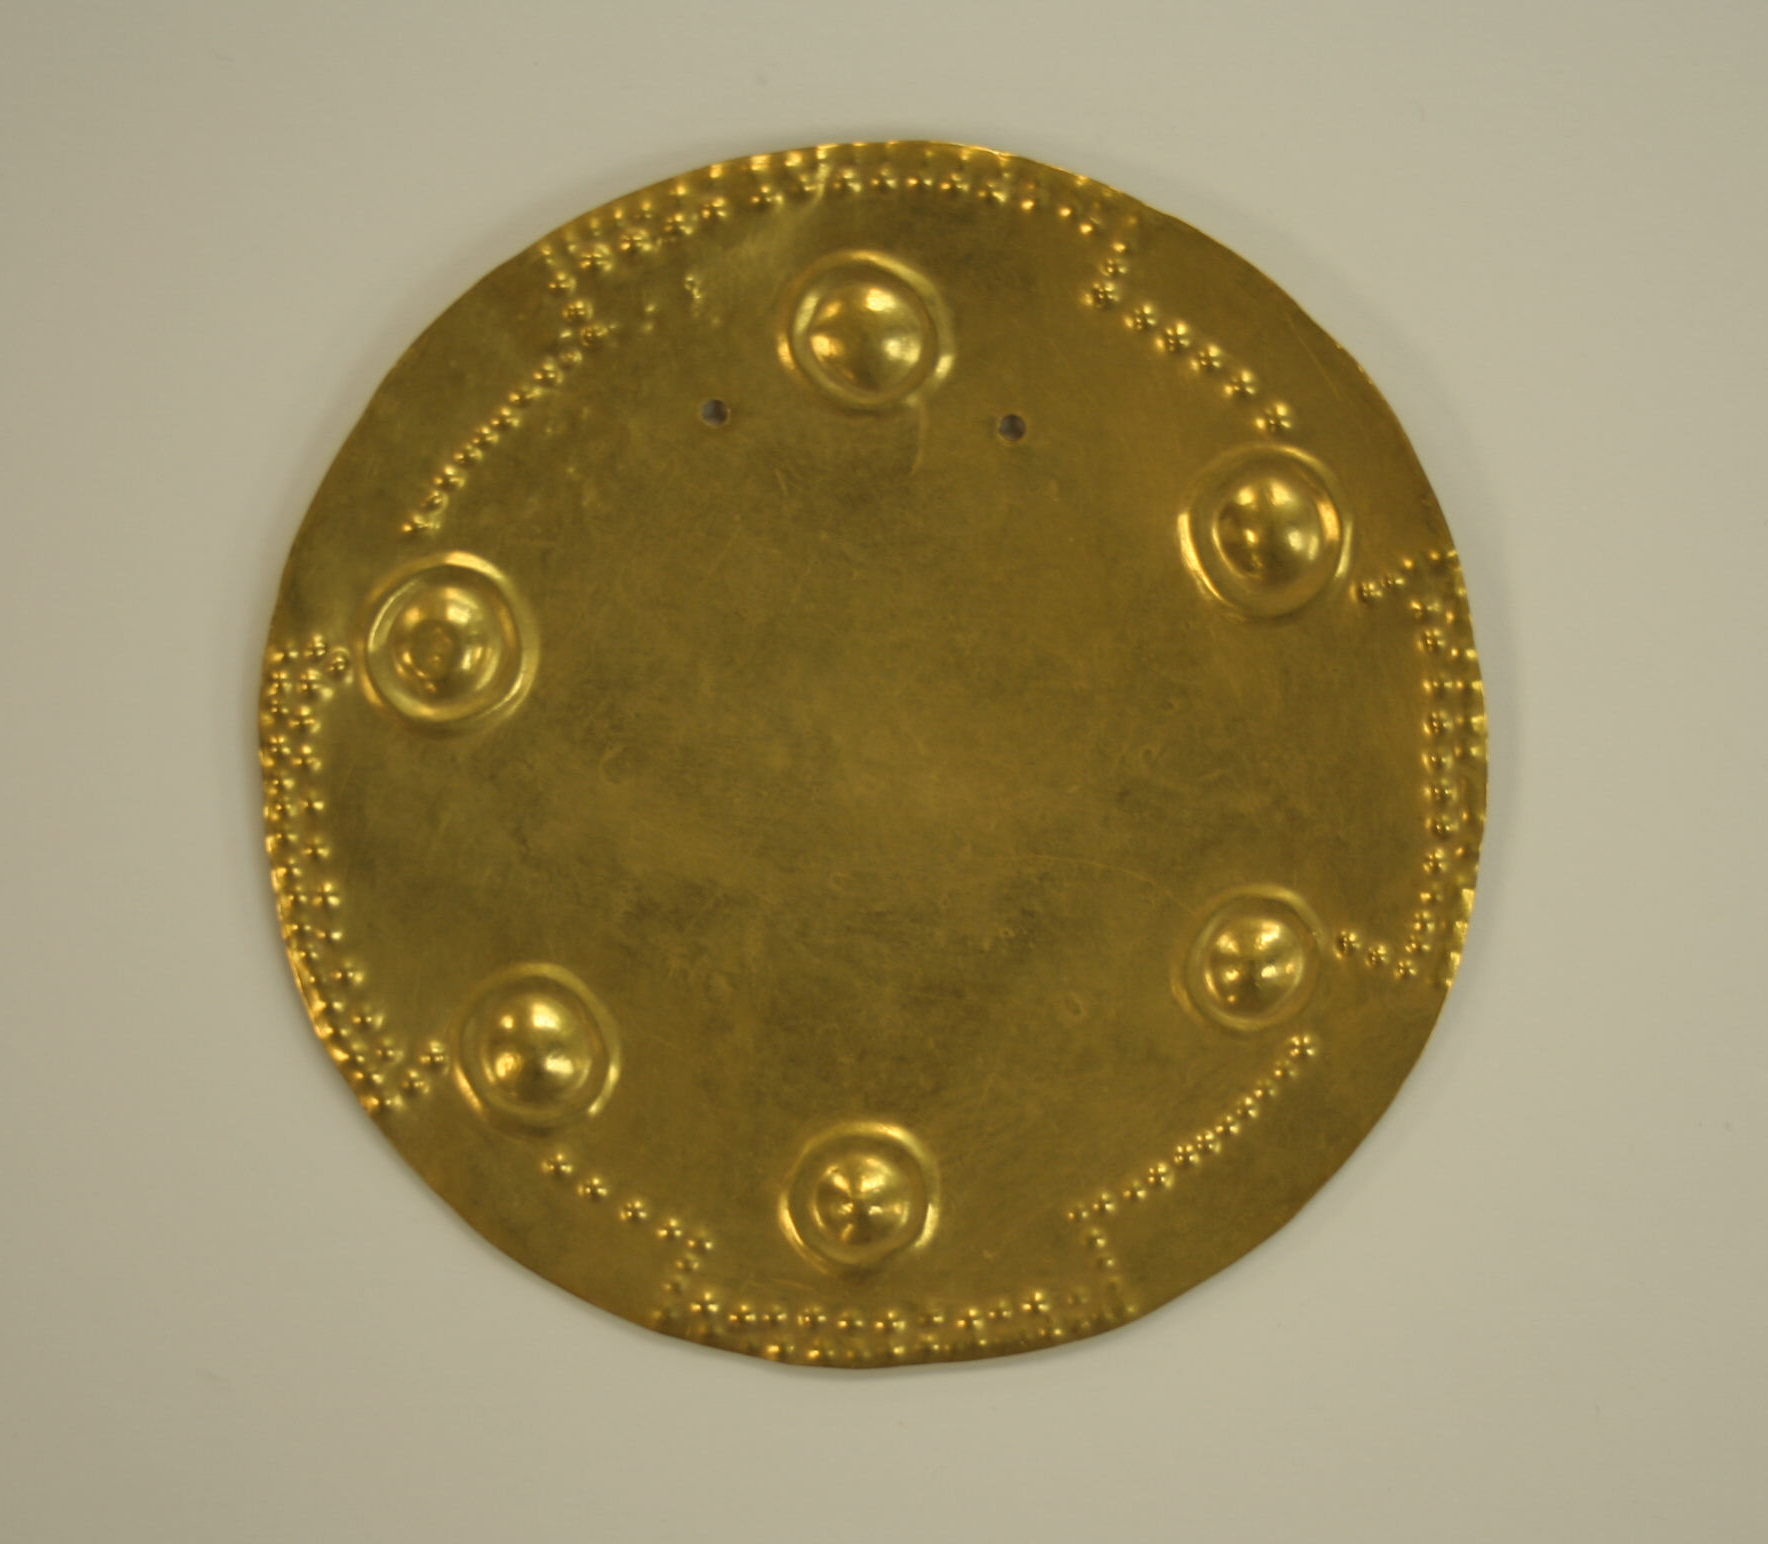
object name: pectoral disk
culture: colombian or panamanian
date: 701-1500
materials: gold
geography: colombia